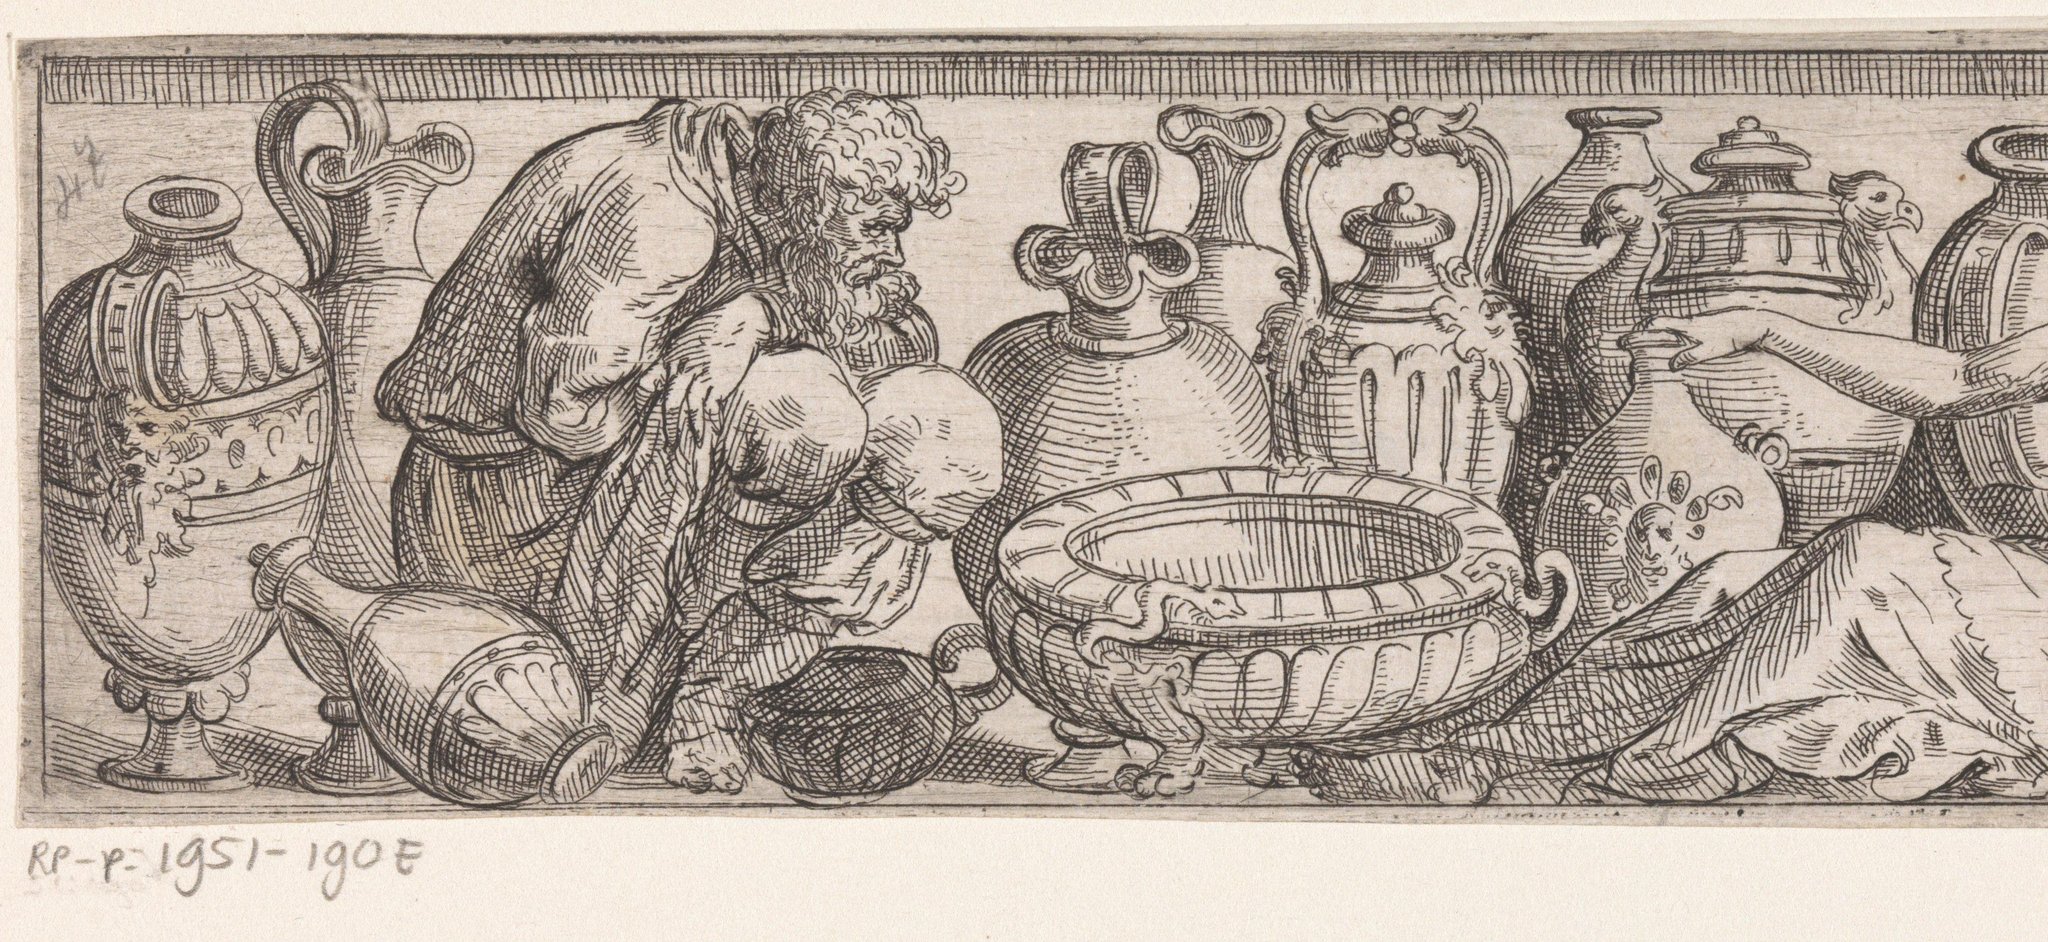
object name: print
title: Figuren tussen wapens en vazen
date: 1583-1638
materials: paper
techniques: etching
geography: italy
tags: sitting figure, garden vase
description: Prent uit een reeks van vijf prenten, plus titelprent.